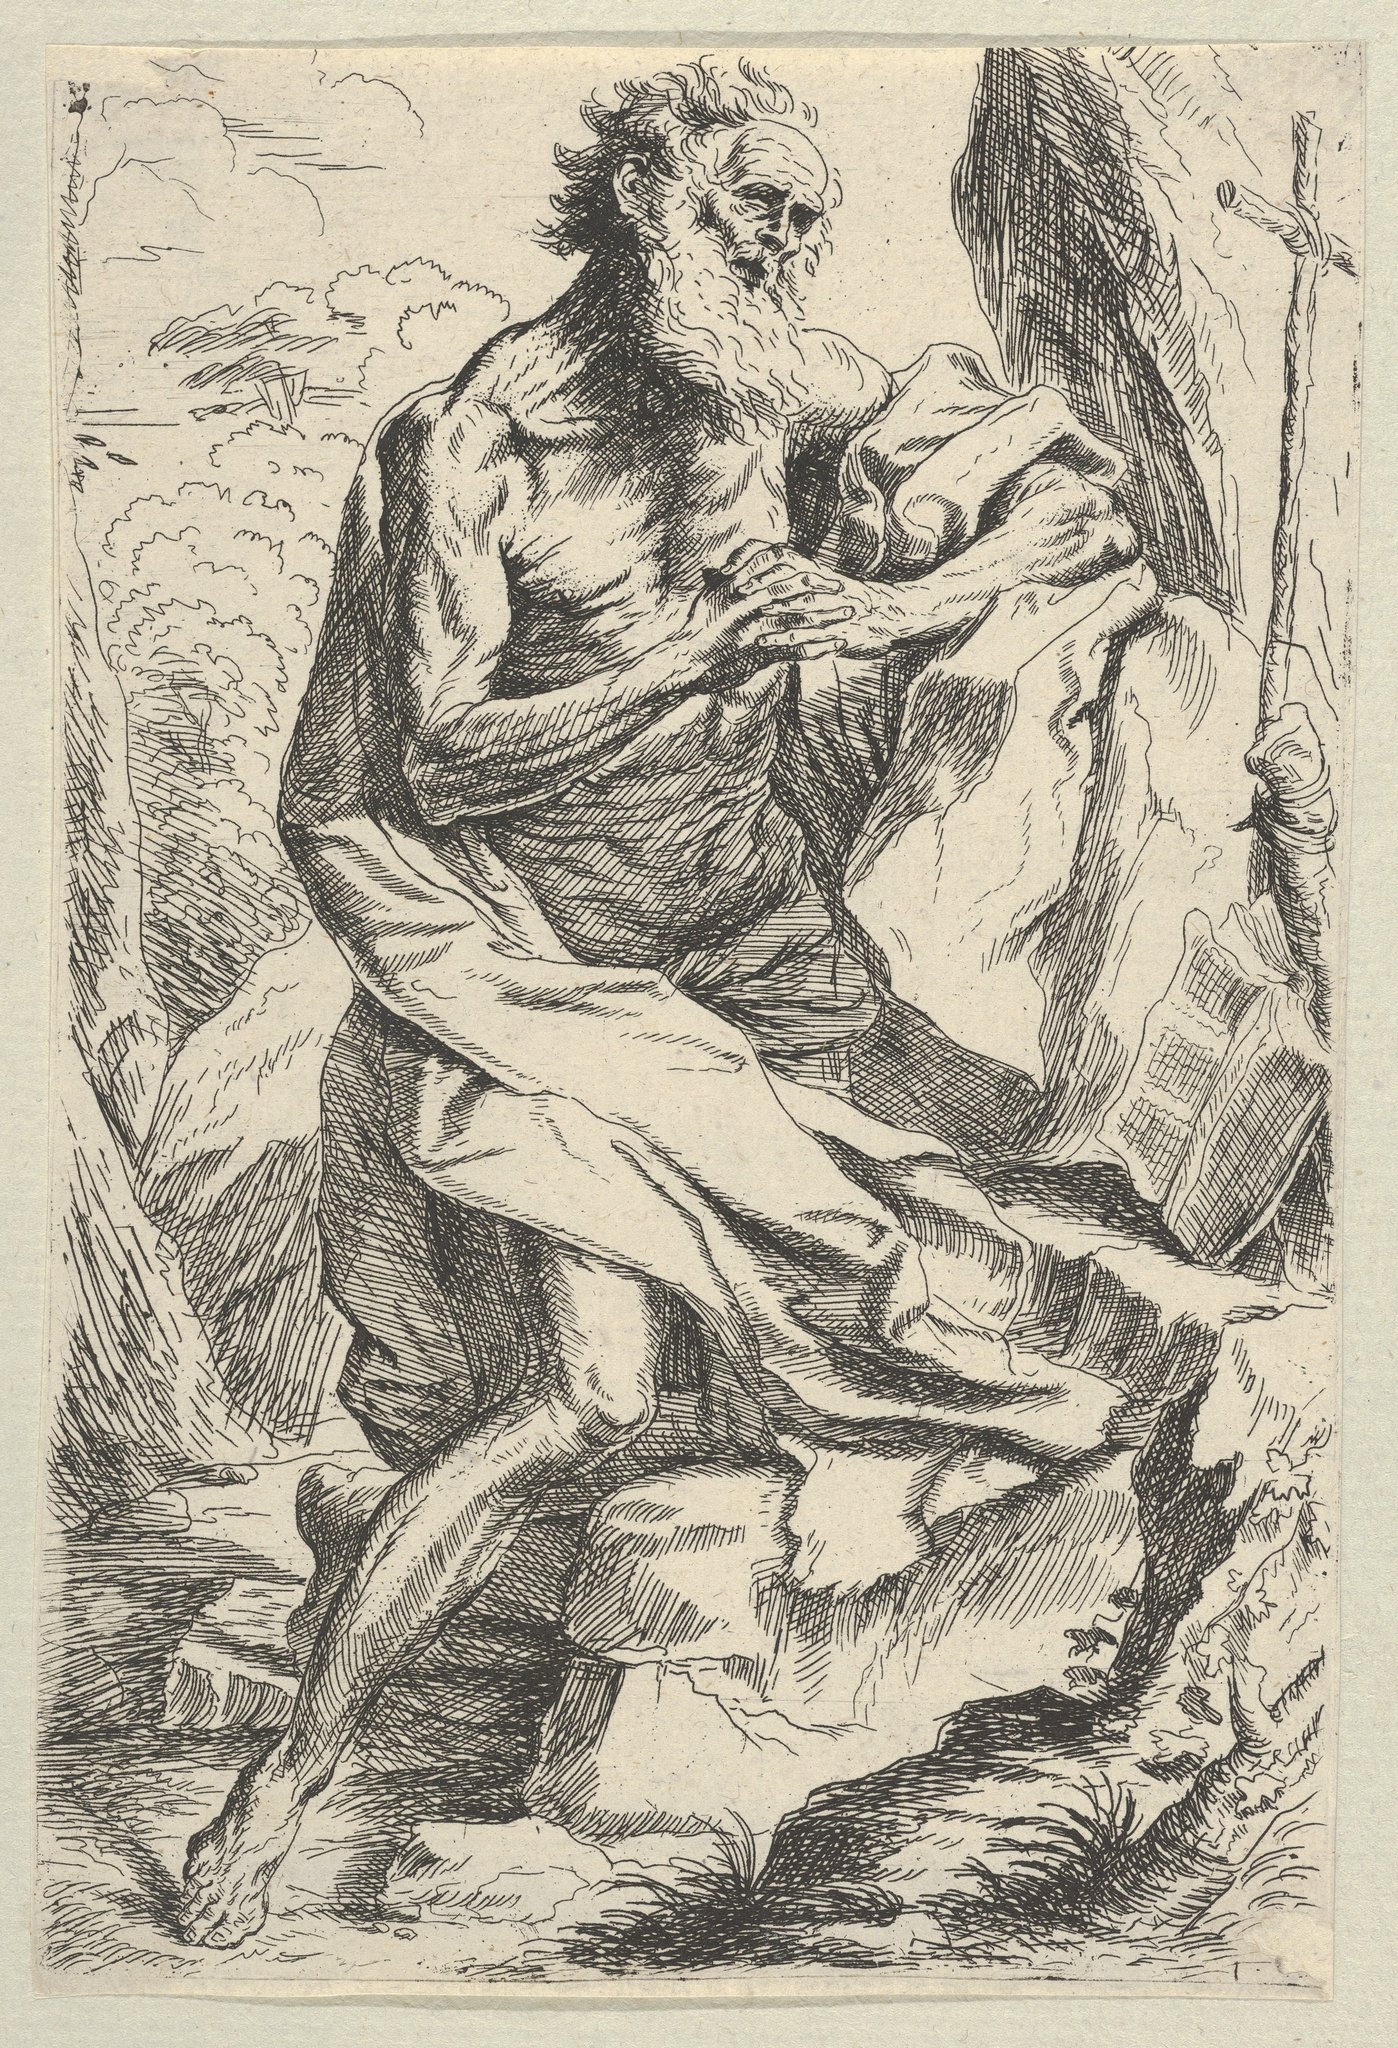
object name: print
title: Saint Jerome kneeling on a rock in front of a cross and an open book facing right, after Reni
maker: anonymous, 17th century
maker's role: artist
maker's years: 1600-1700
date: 1600-1640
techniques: etching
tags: saint jerome,cross,praying